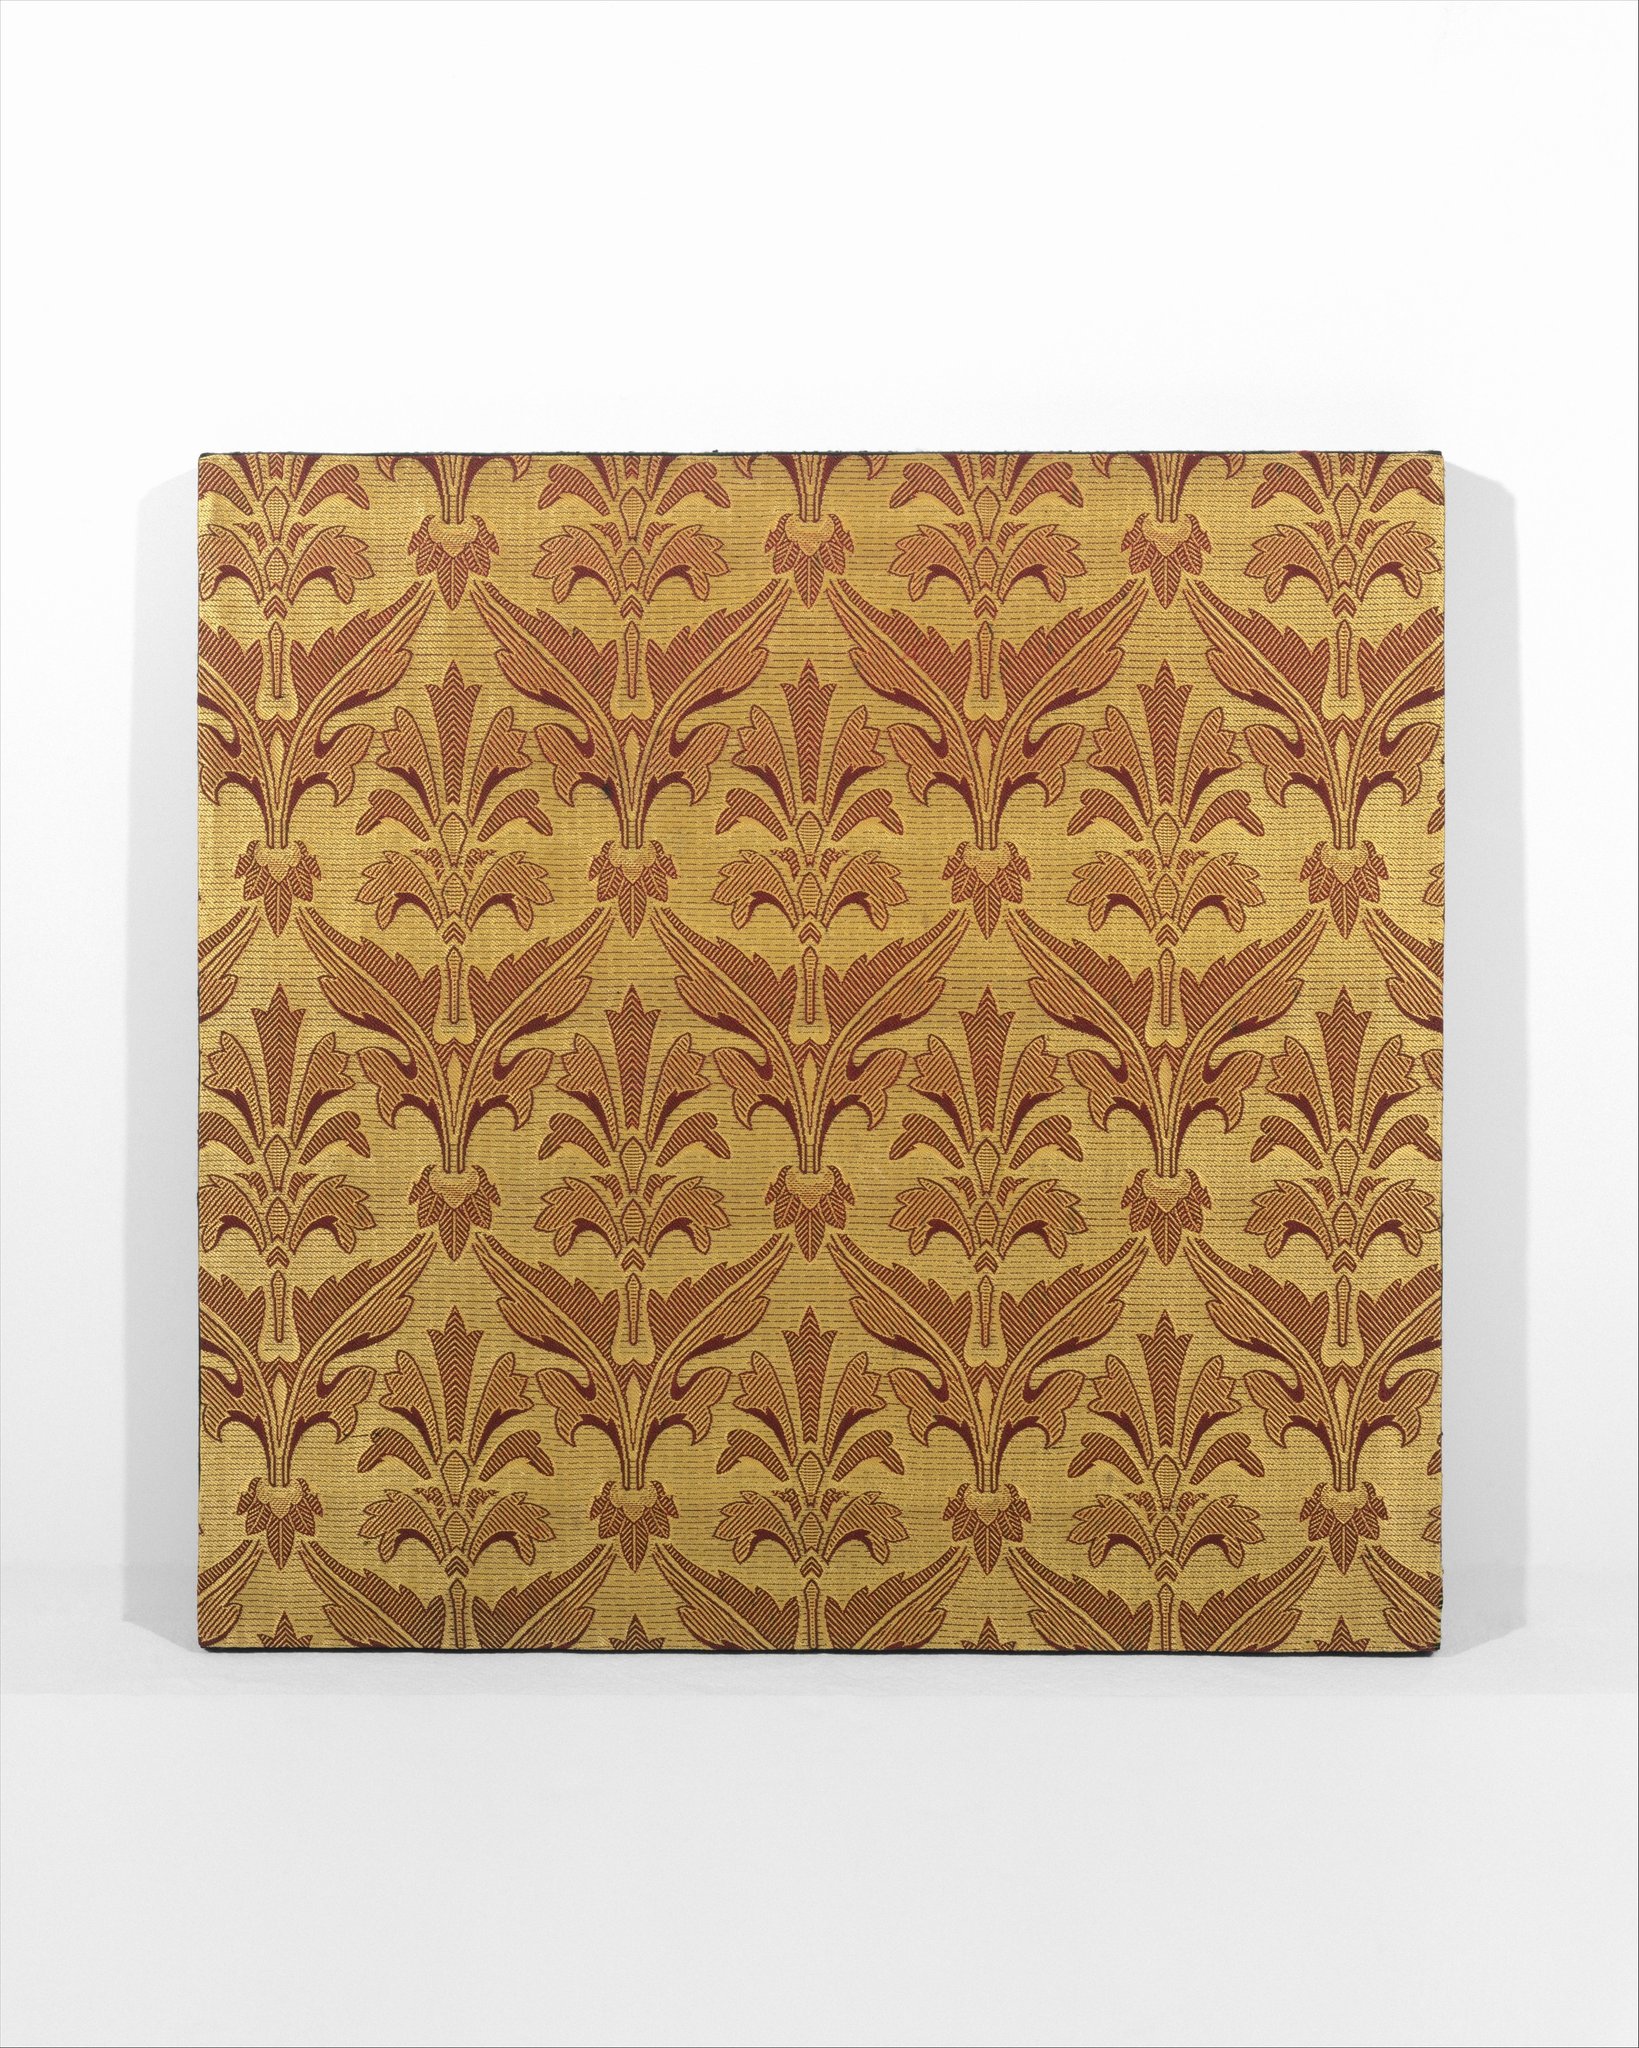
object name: piece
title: Italian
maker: owen jones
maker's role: designer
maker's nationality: british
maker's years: 1809-1874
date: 1873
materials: silk